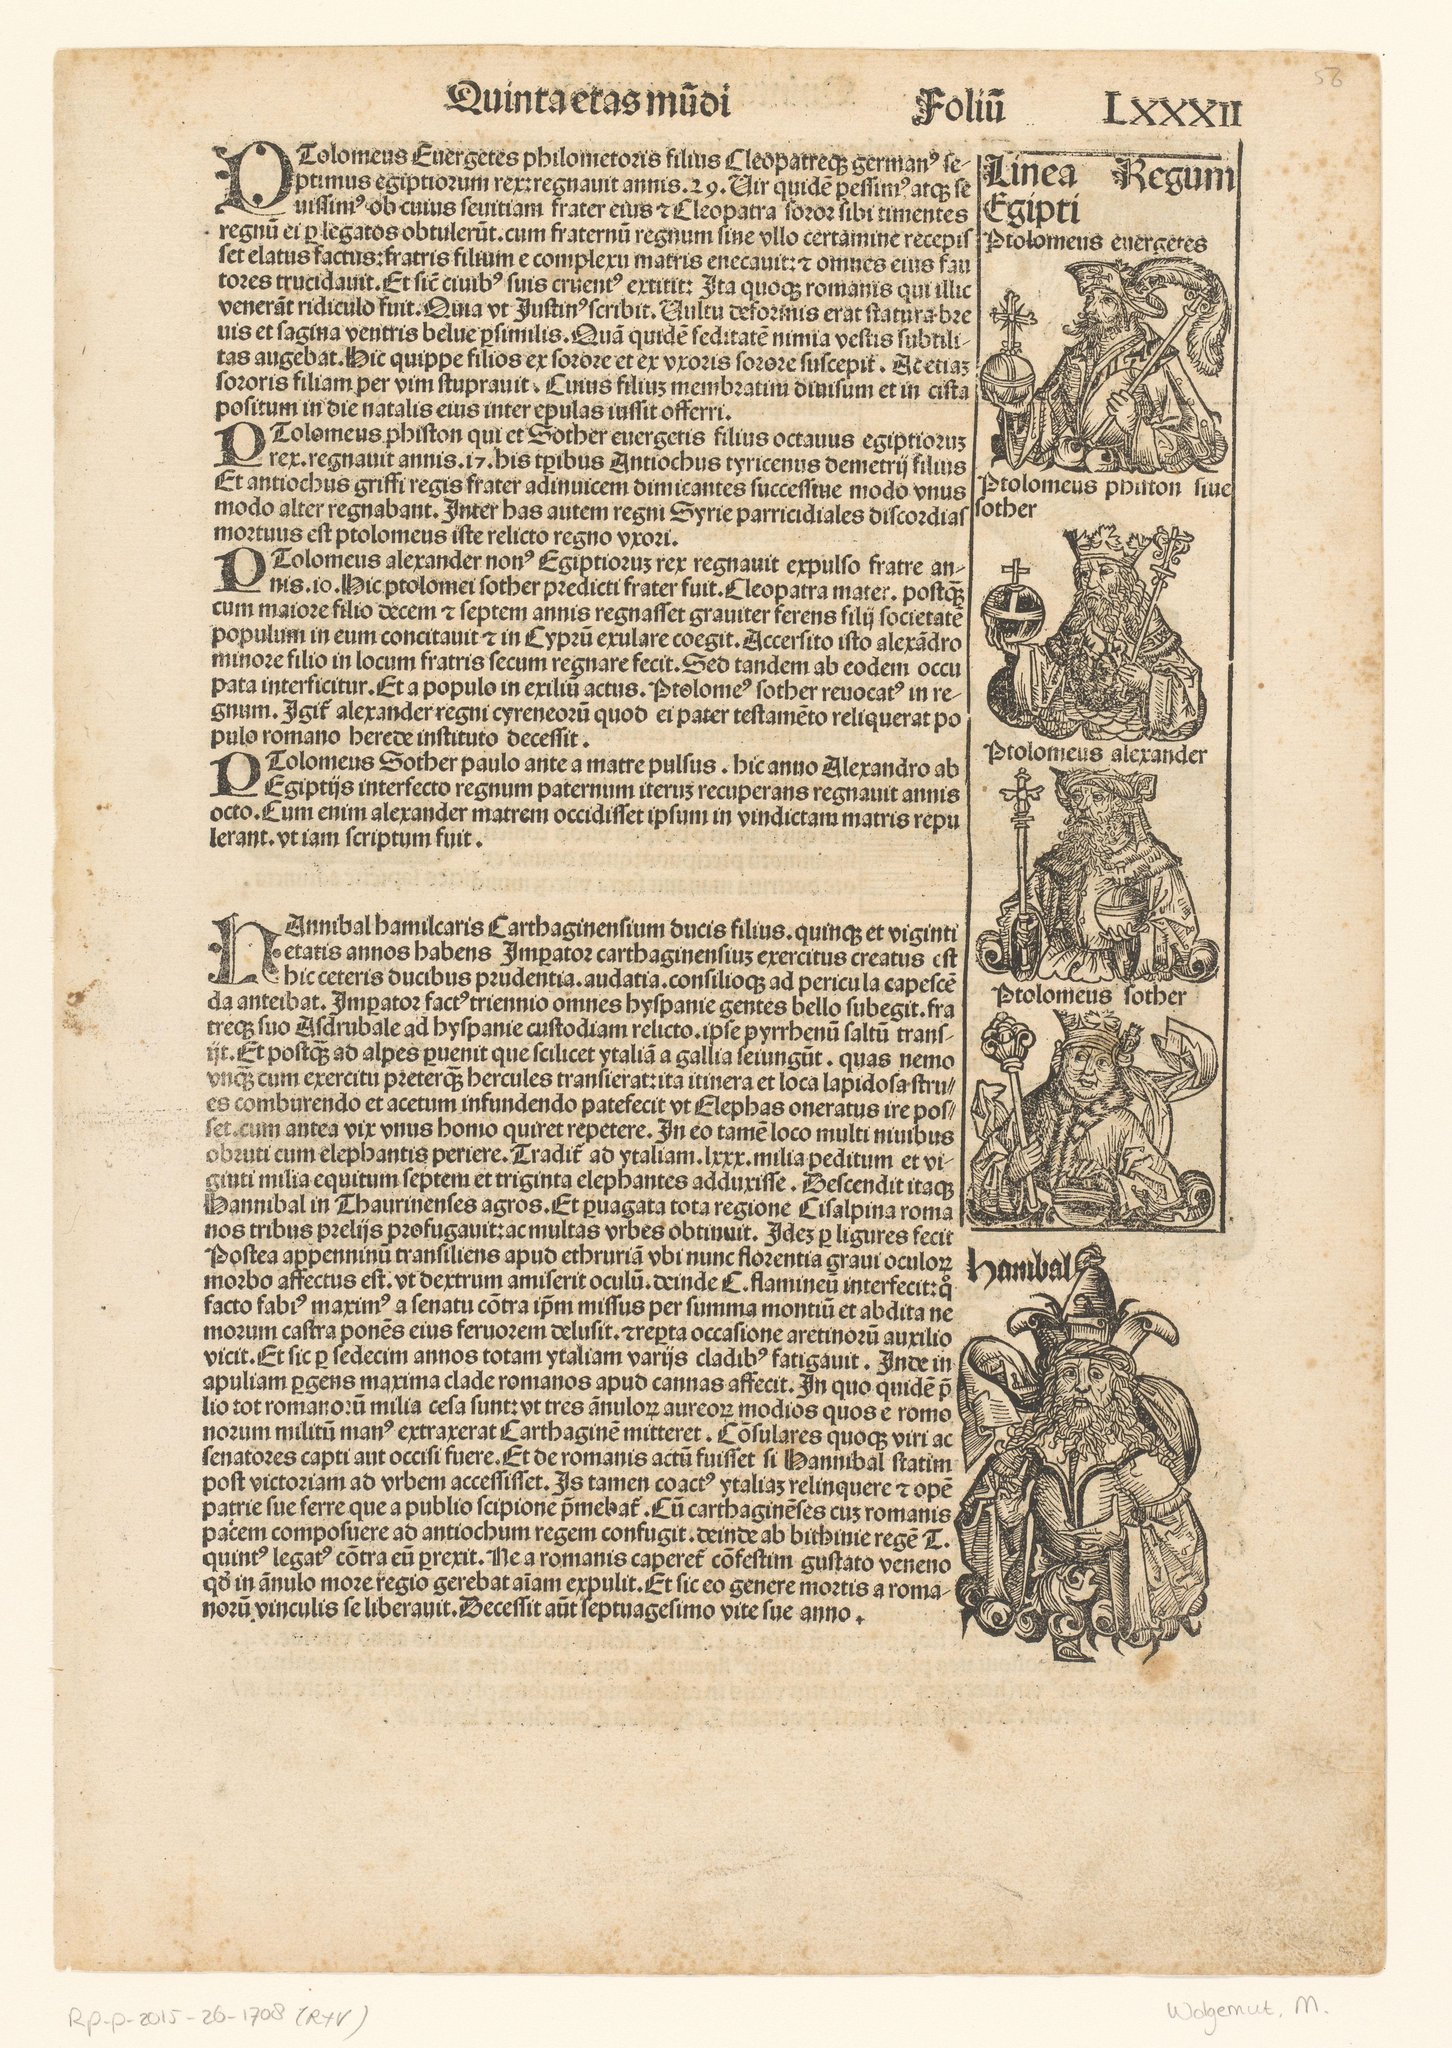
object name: page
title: Bladzijde uit de Neurenbergkroniek van Schedel, folio 82r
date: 1493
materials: paper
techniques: letterpress printing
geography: nuremberg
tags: ruler, sovereign, (story of) hannibal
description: De Neurenbergkroniek van Hartmann Schedel is bekend om zijn vele illustraties. Voor de 1804 houtsneden werden 441 verschillende houtblokken gemaakt. Vele houtblokken werden dus meer dan eens gebruikt. Titels bij de figuren identificeren de voorstelling of de voorgestelde personen. Deze pagina is afkomstig uit de Latijnse uitgave van 1493.